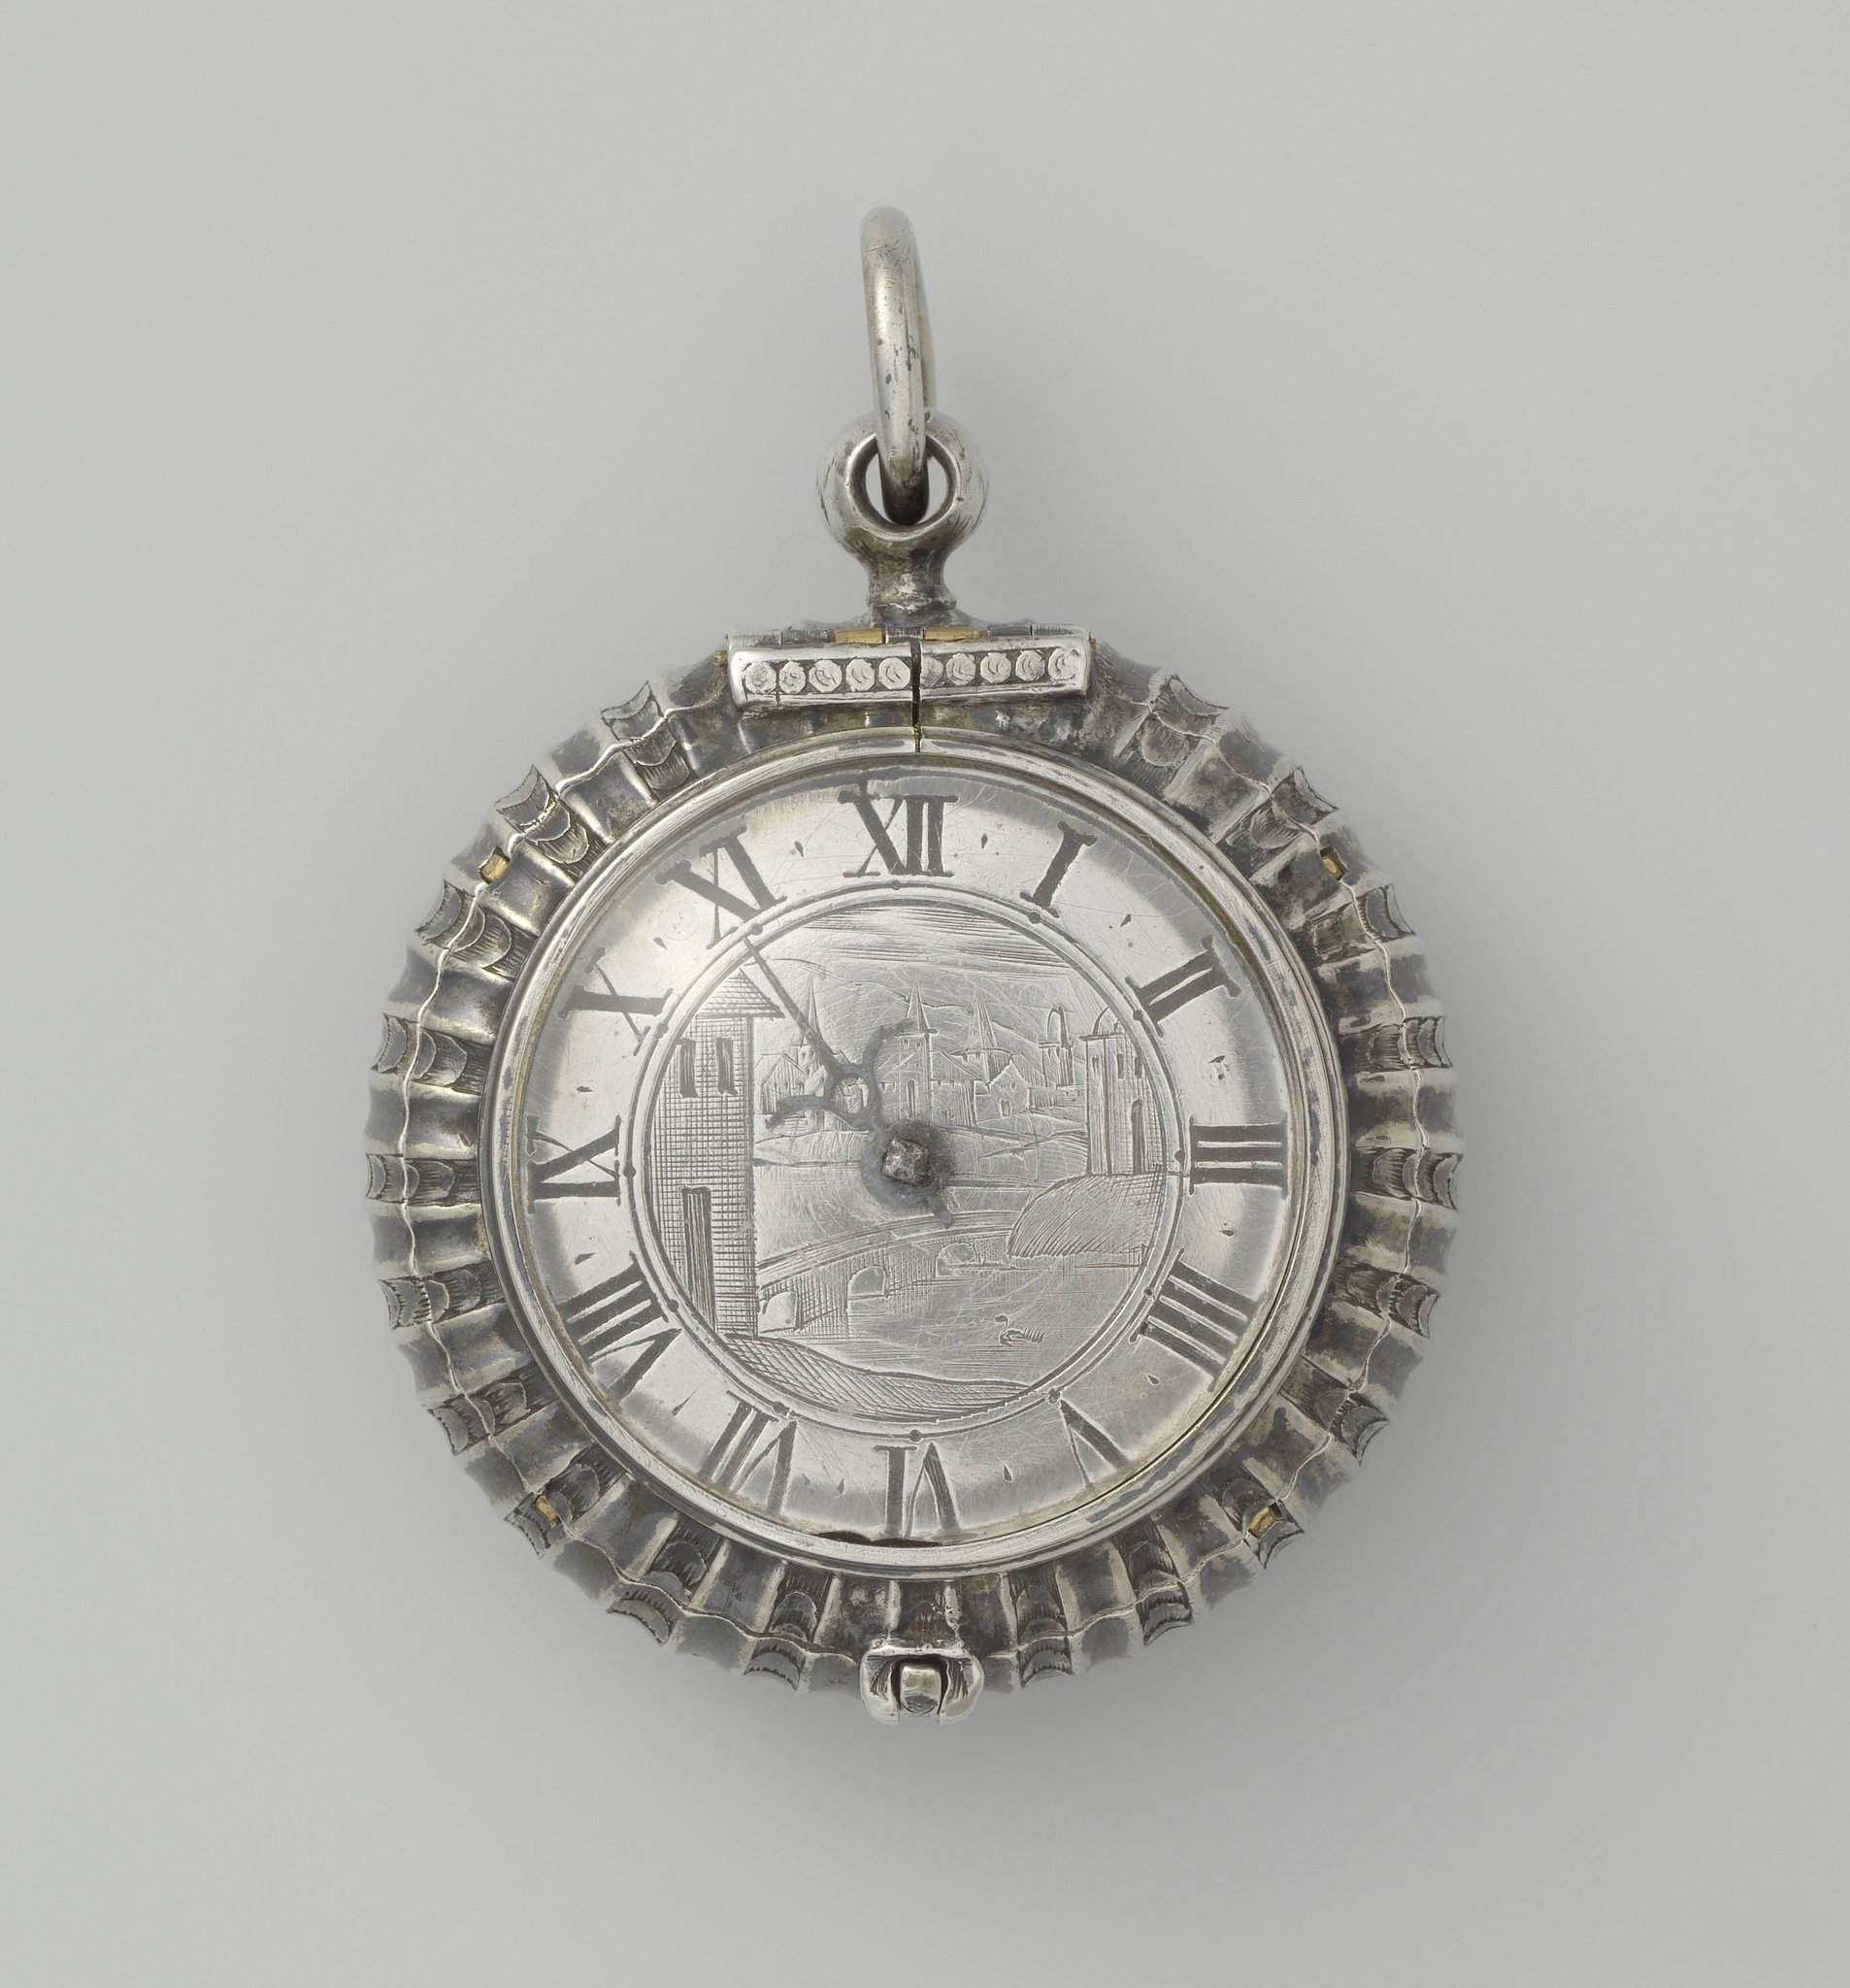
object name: jewellery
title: Men's Watch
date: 1650-1675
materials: copper, silver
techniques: engraving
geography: switzerland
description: Herenhorloge van zilver met komvormige achterbodem die straalsgewijs gecanneleerd is. Op de zilveren wijzerplaat is een rivierlandschap gegraveeerd.